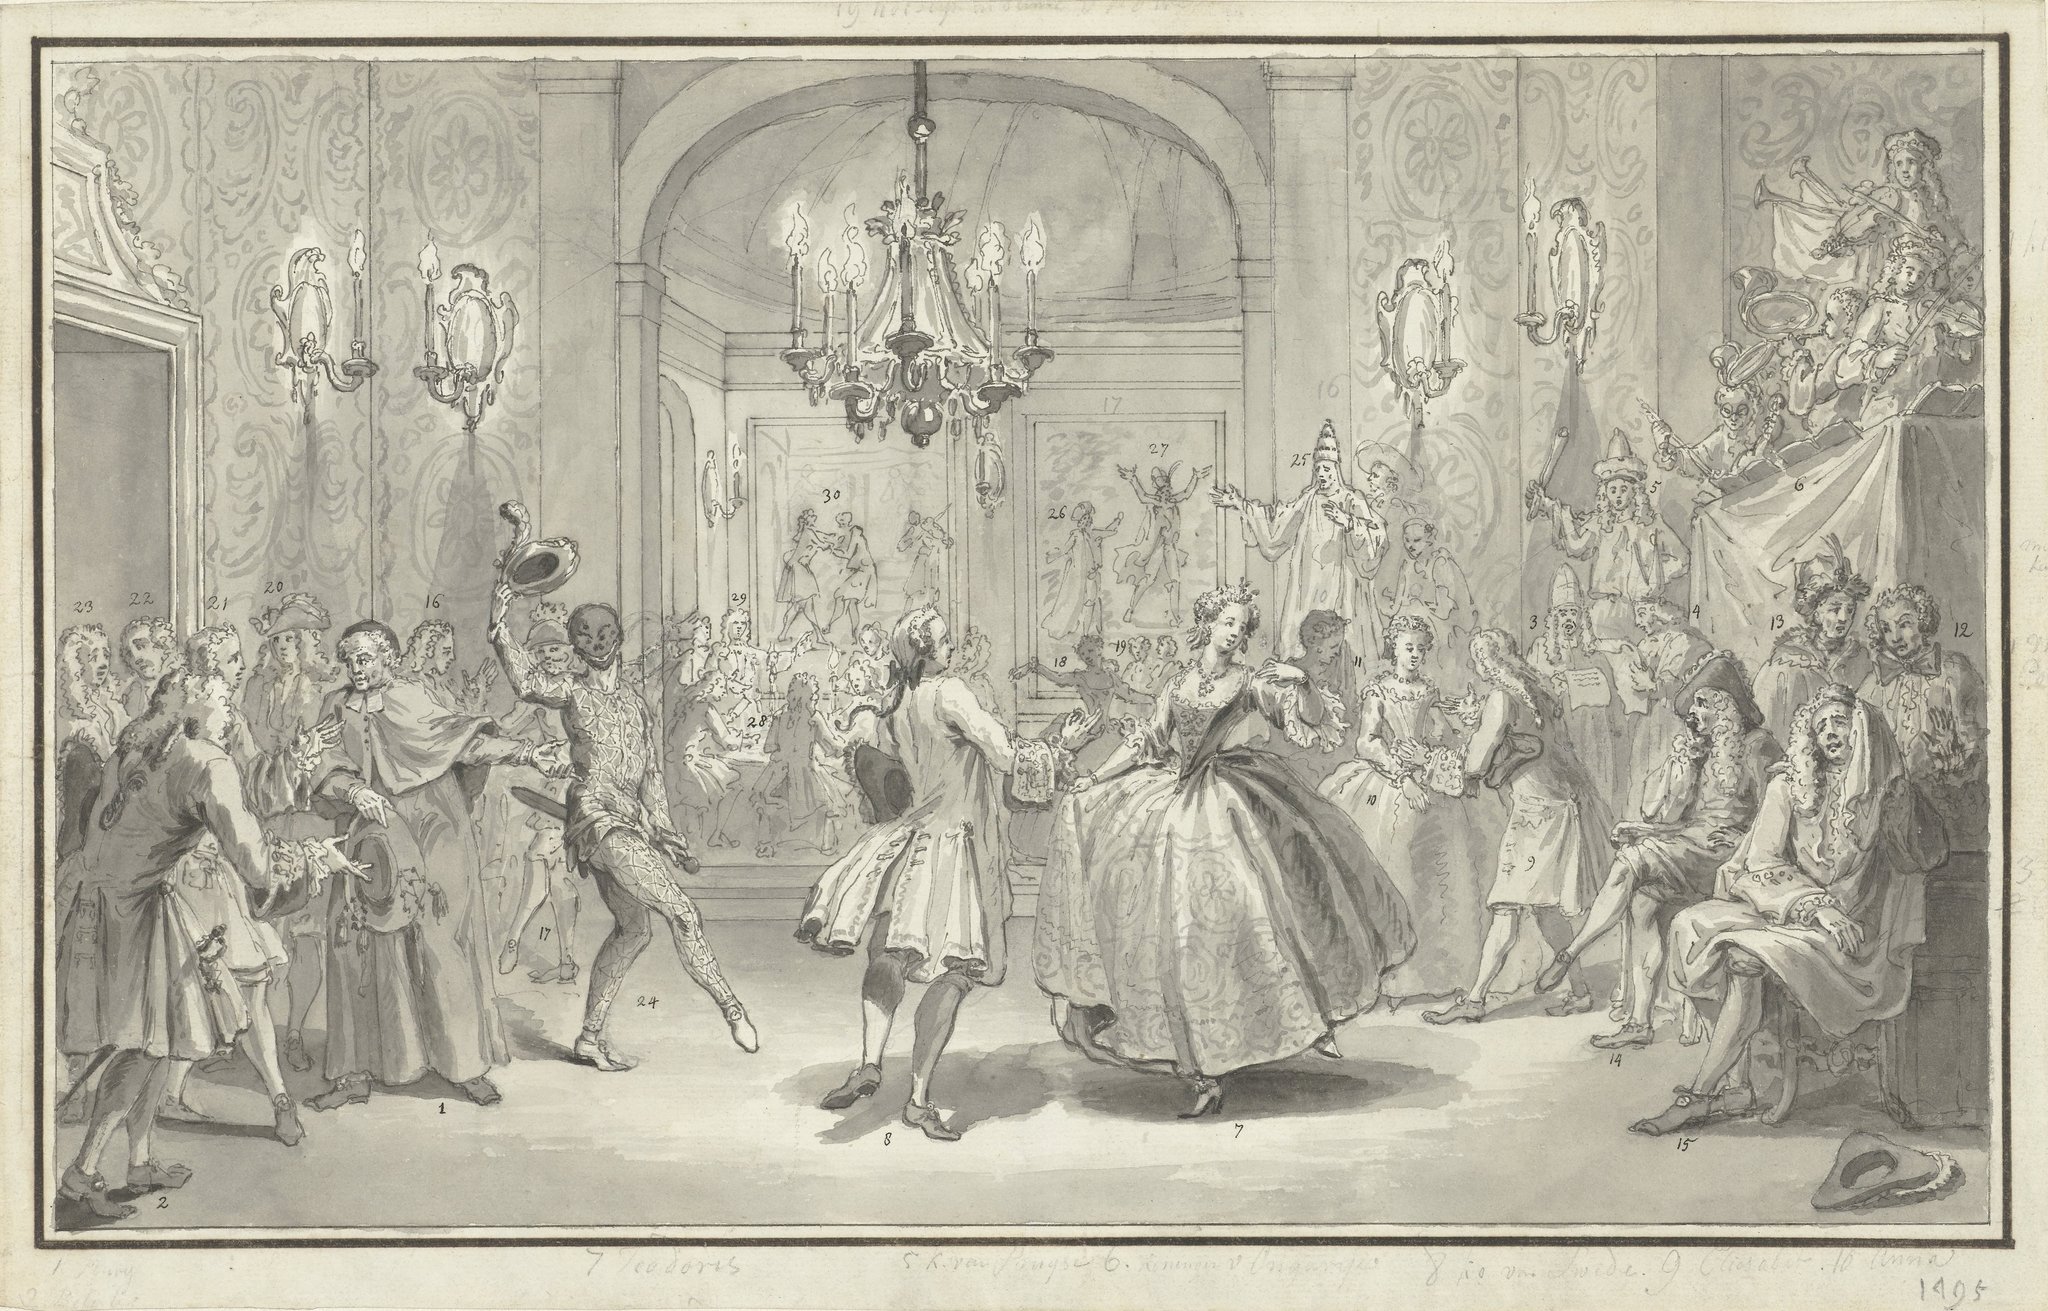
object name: drawing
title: Bal der Europese vorsten, 1742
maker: simon fokke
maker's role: draughtsman, print maker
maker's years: 1712-1784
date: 1740-1742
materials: paper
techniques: pouncing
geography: northern netherlands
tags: france, vienna, maria theresia (rooms-duits keizerin), karel vii albrecht (duits keizer), berlin, frederick ii (king of prussia), dancing, ball, formal dance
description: Het plechtige bal der Europese vorsten, 1742. Bal gegeven door de keurvorst van Beieren in een door kaarsen verlichte balzaal waarin centraal aartshertogin Maria Theresia met koning Frederik van Pruisen danst. Theodor von Neuhoff, de koning van Corsica, danst mee in een harlekijnspak. Andere vorsten kijken toe. Allegorie op de Oostenrijkse successieoorlog. Ontwerp voor een prent.